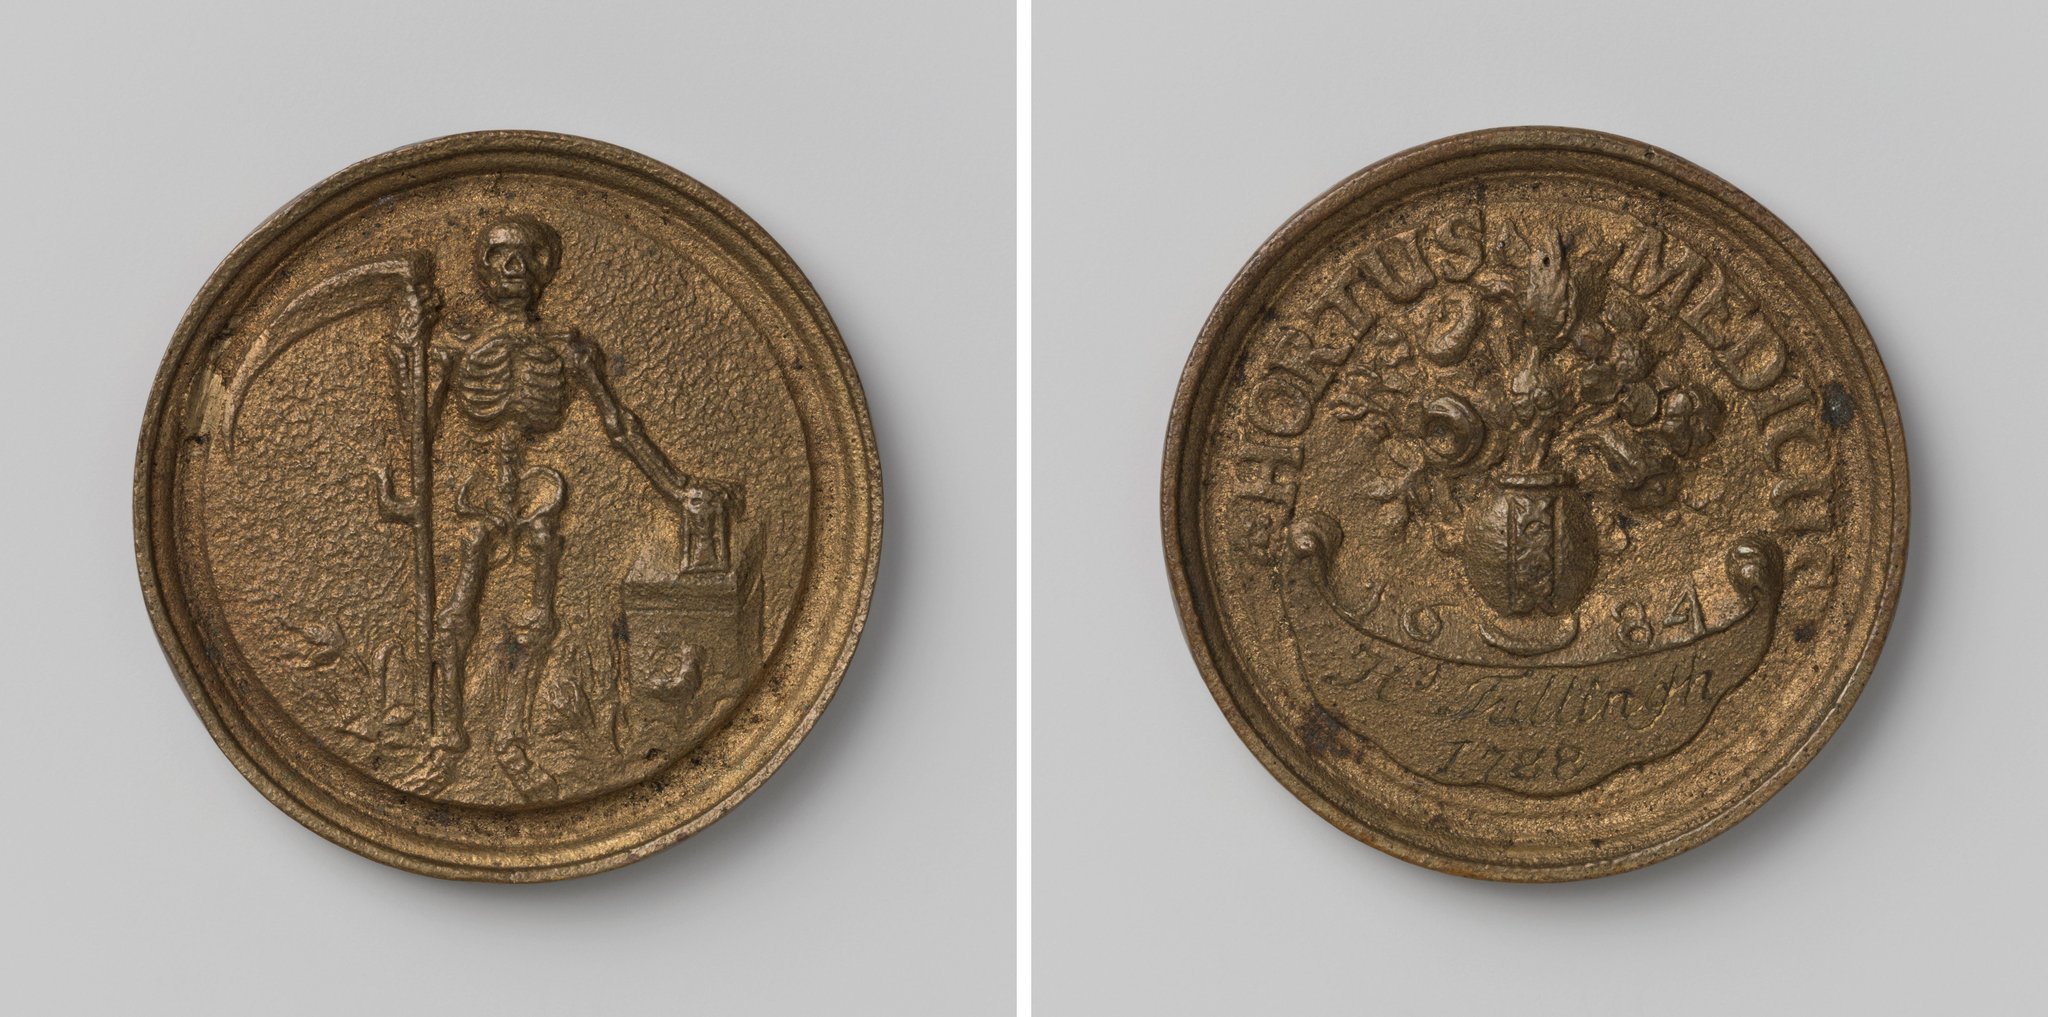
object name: medal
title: Chirurgijnsgilde te Amsterdam, toegangspenning voor de hortus medicus van H. Tullingh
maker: Anonymous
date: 1788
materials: brass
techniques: casting, engraving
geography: amsterdam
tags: amsterdam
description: Messing penning. Voorzijde: Dood, afgebeeld als geraamte, in bloemenveld met zeis in rechterhand en met linkerhand op zandloper, die op sokkel staat. Keerzijde: vaas met bloemen tussen jaartal; op vaas:wapenschild boven cartouche binnen omschrift